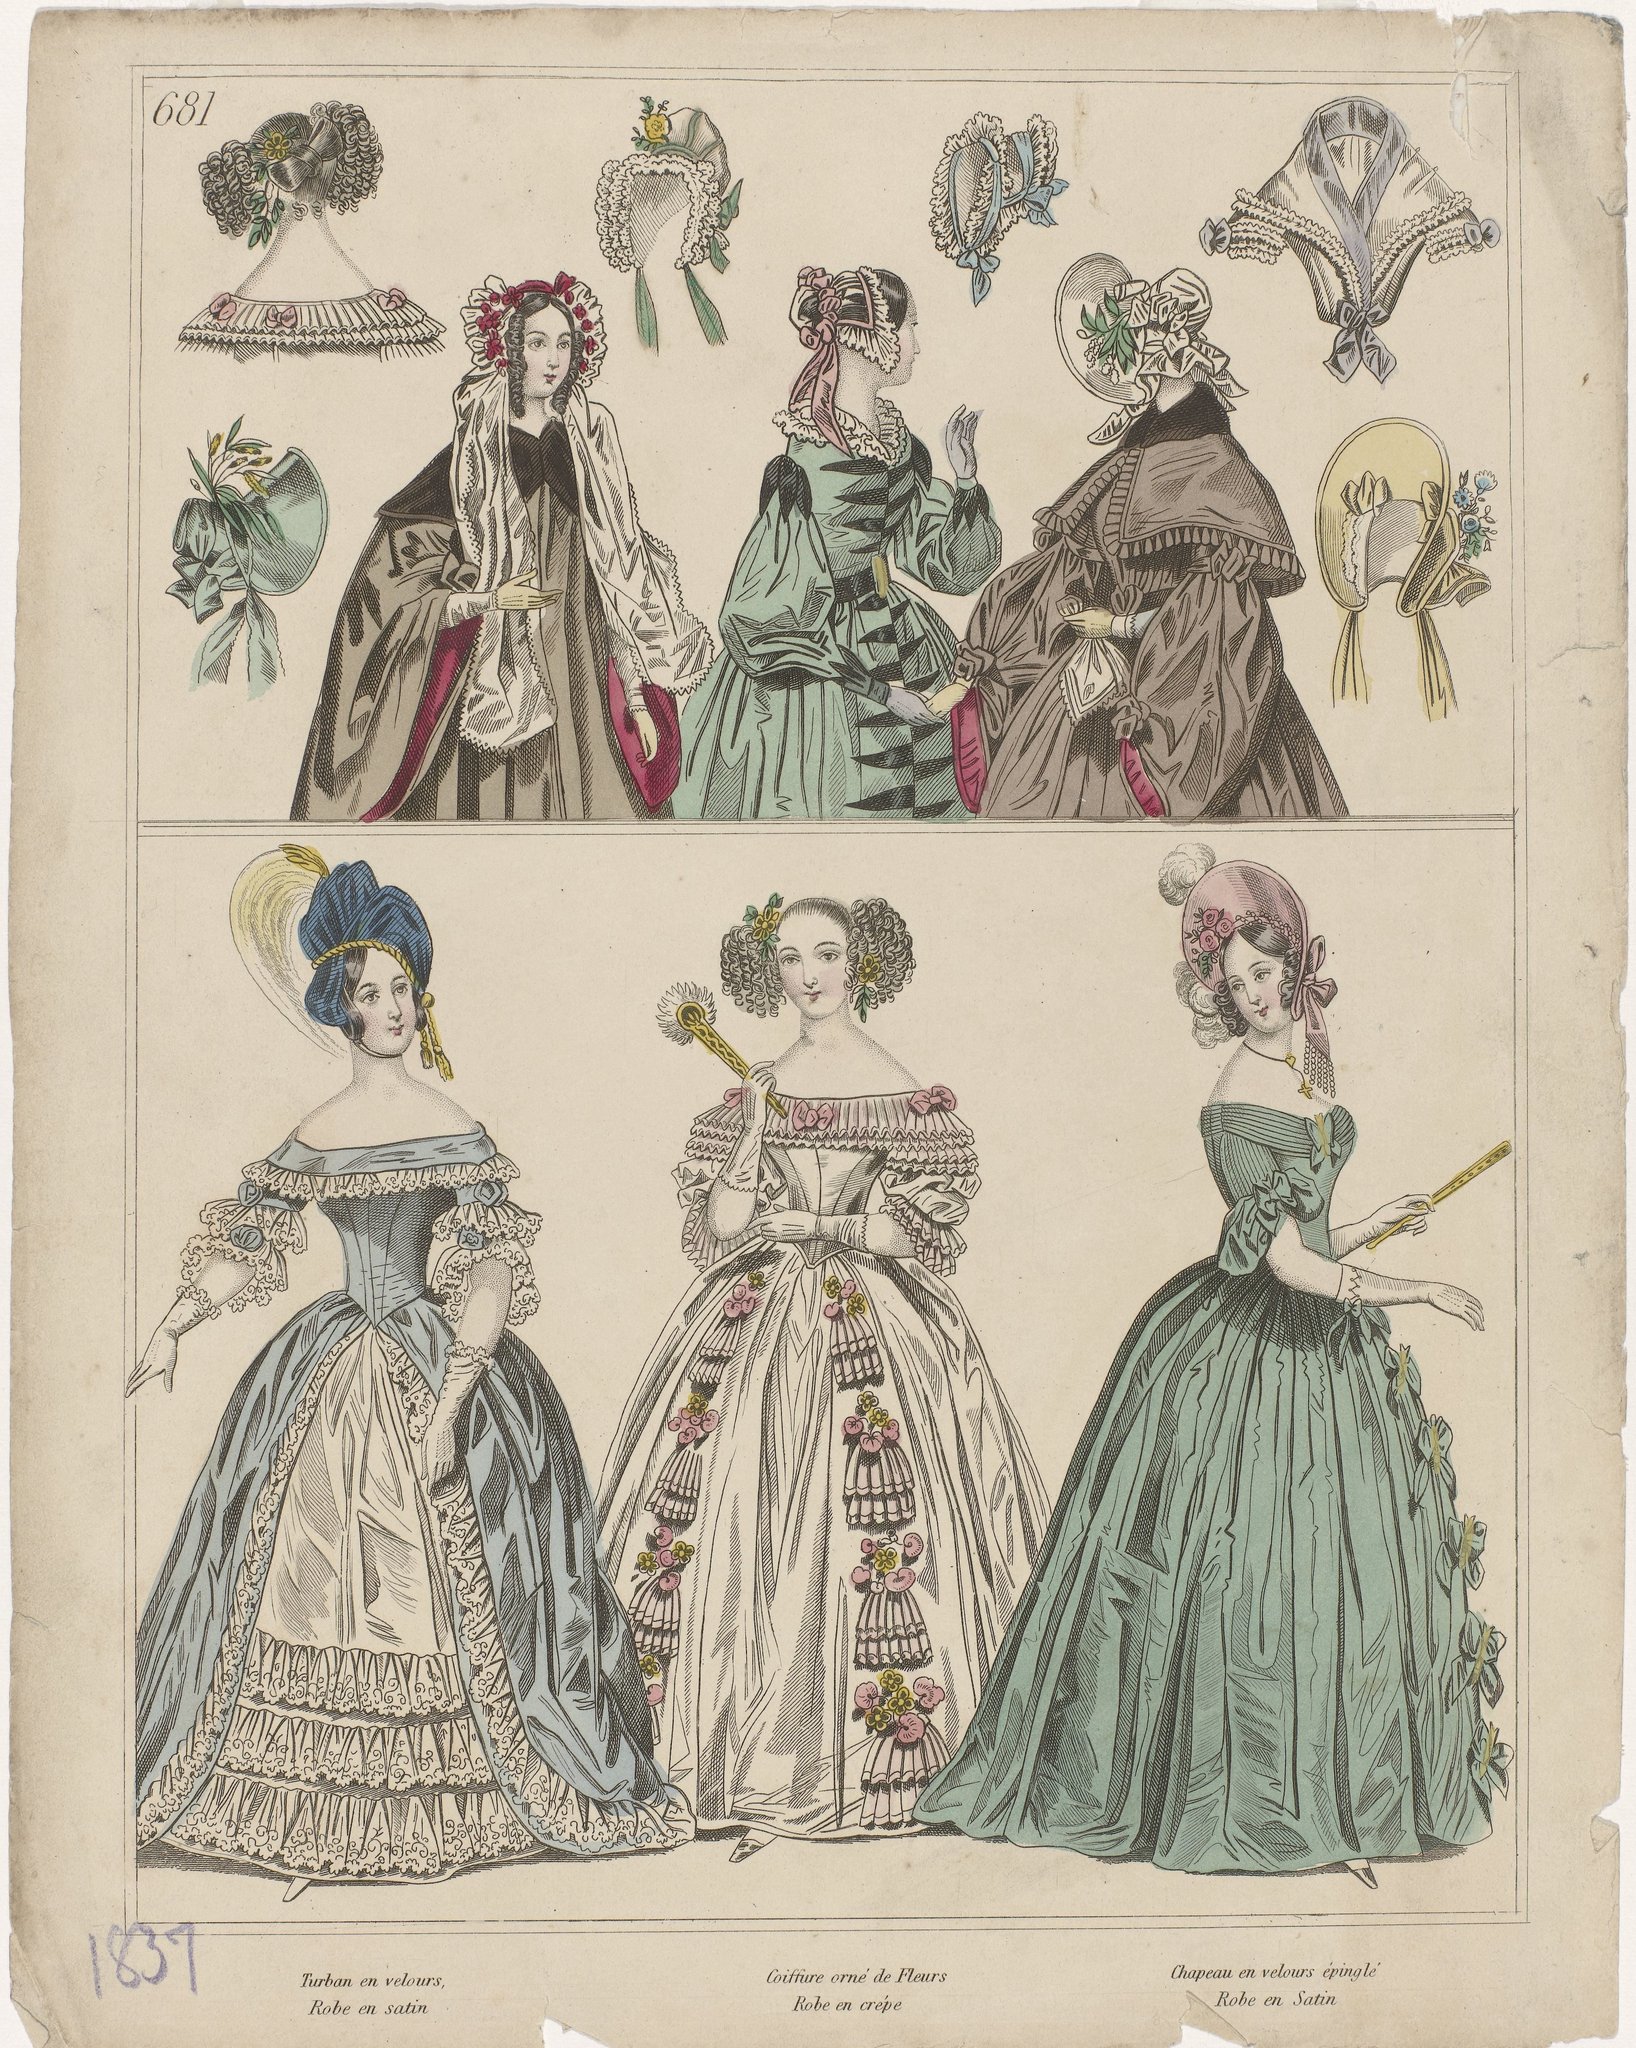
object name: fashion print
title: Townsend's Monthly Selection of Parisian Costumes, 1837, No. 681 : Turban en velours (...)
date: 1837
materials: paper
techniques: engraving, hand coloring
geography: london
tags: flowers, head-gear: turban (+ women's clothes), styles of hairdress - aa - ~ women, head-gear: cap (+ women's clothes), fashion plates, head-gear: hat (+ women's clothes), dress, gown (+ women's clothes), fan (+ women's clothes), sleeves (+ women's clothes)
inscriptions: caption: ‘Turban en velours, Robe en satin / Coiffure orné de Fleurs Robe en crépe / Chapeau en velours épinglé Robe en Satin.’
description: In het bovenste kader: mutsen, luifelhoeden, kapsel, canezou (?) en mantels. In het onderste kader drie vrouwen, van links naar rechts: tulband van fluweel en japon van satijn. 'Coiffure' versierd met bloemen. Japon van crêpe. Hoed van 'velours épinglé'. Japon van satijn. Prent uit het modetijdschrift Townsends Monthly Selection of Parisian Costumes (London 1823-1888).